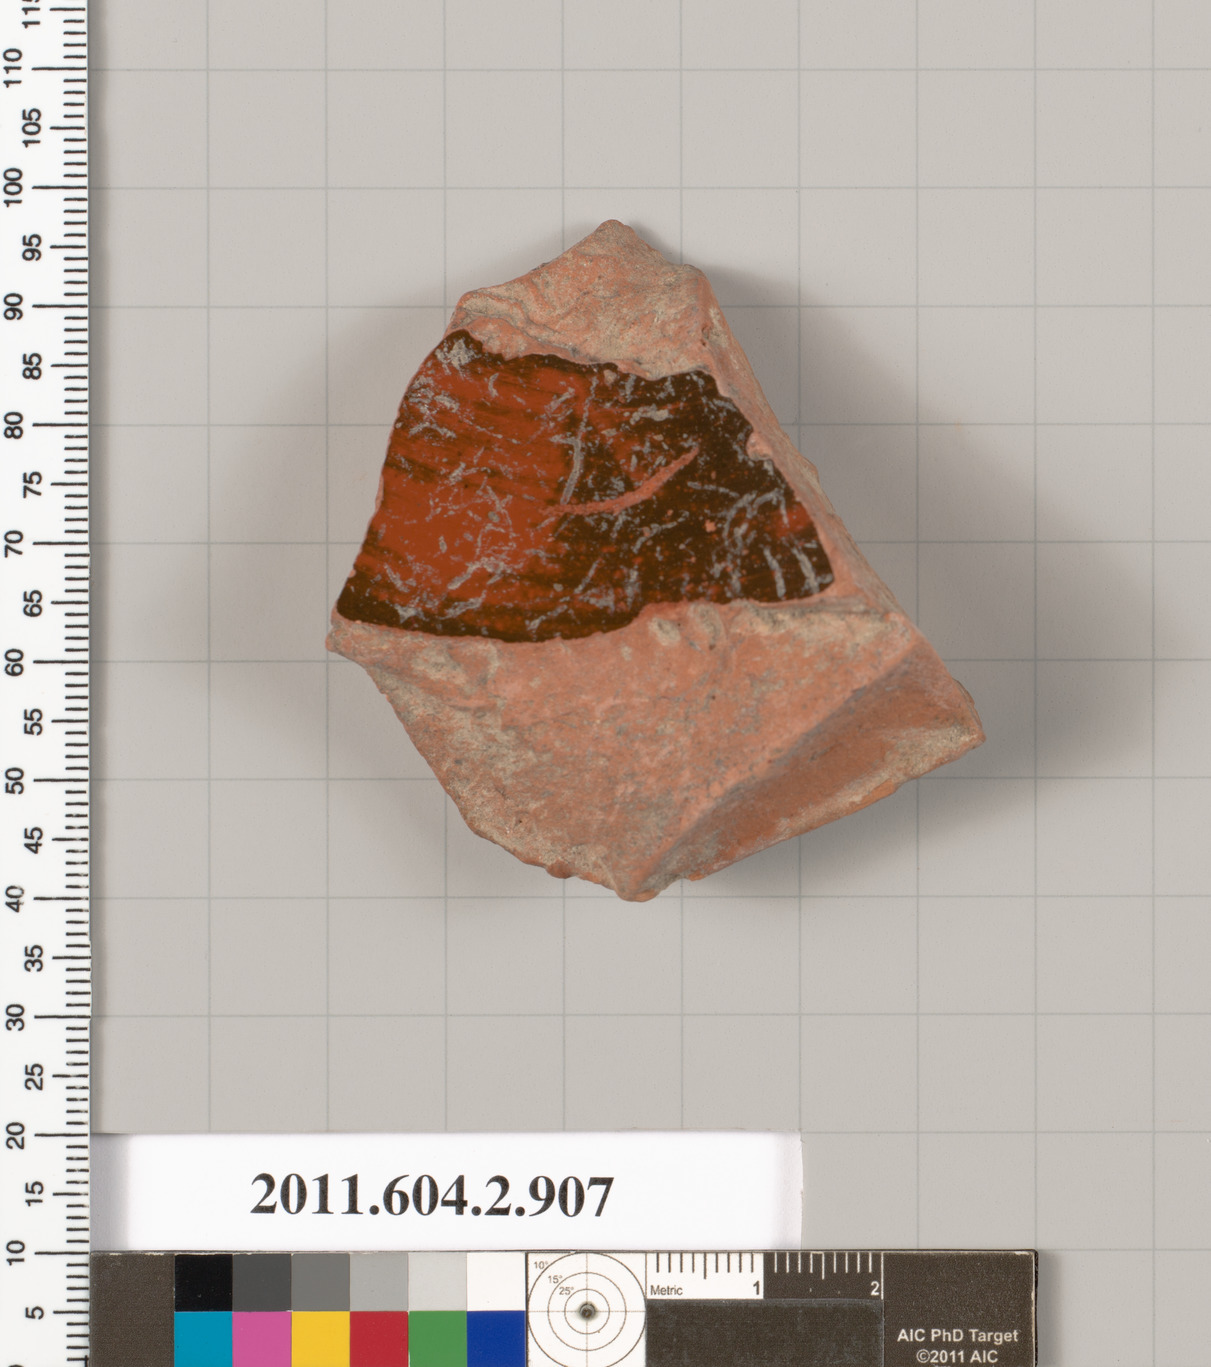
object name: bell krater fragment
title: Terracotta fragment of a bell-krater (bowl for mixing wine and water)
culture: greek, attic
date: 460-440 BCE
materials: terracotta